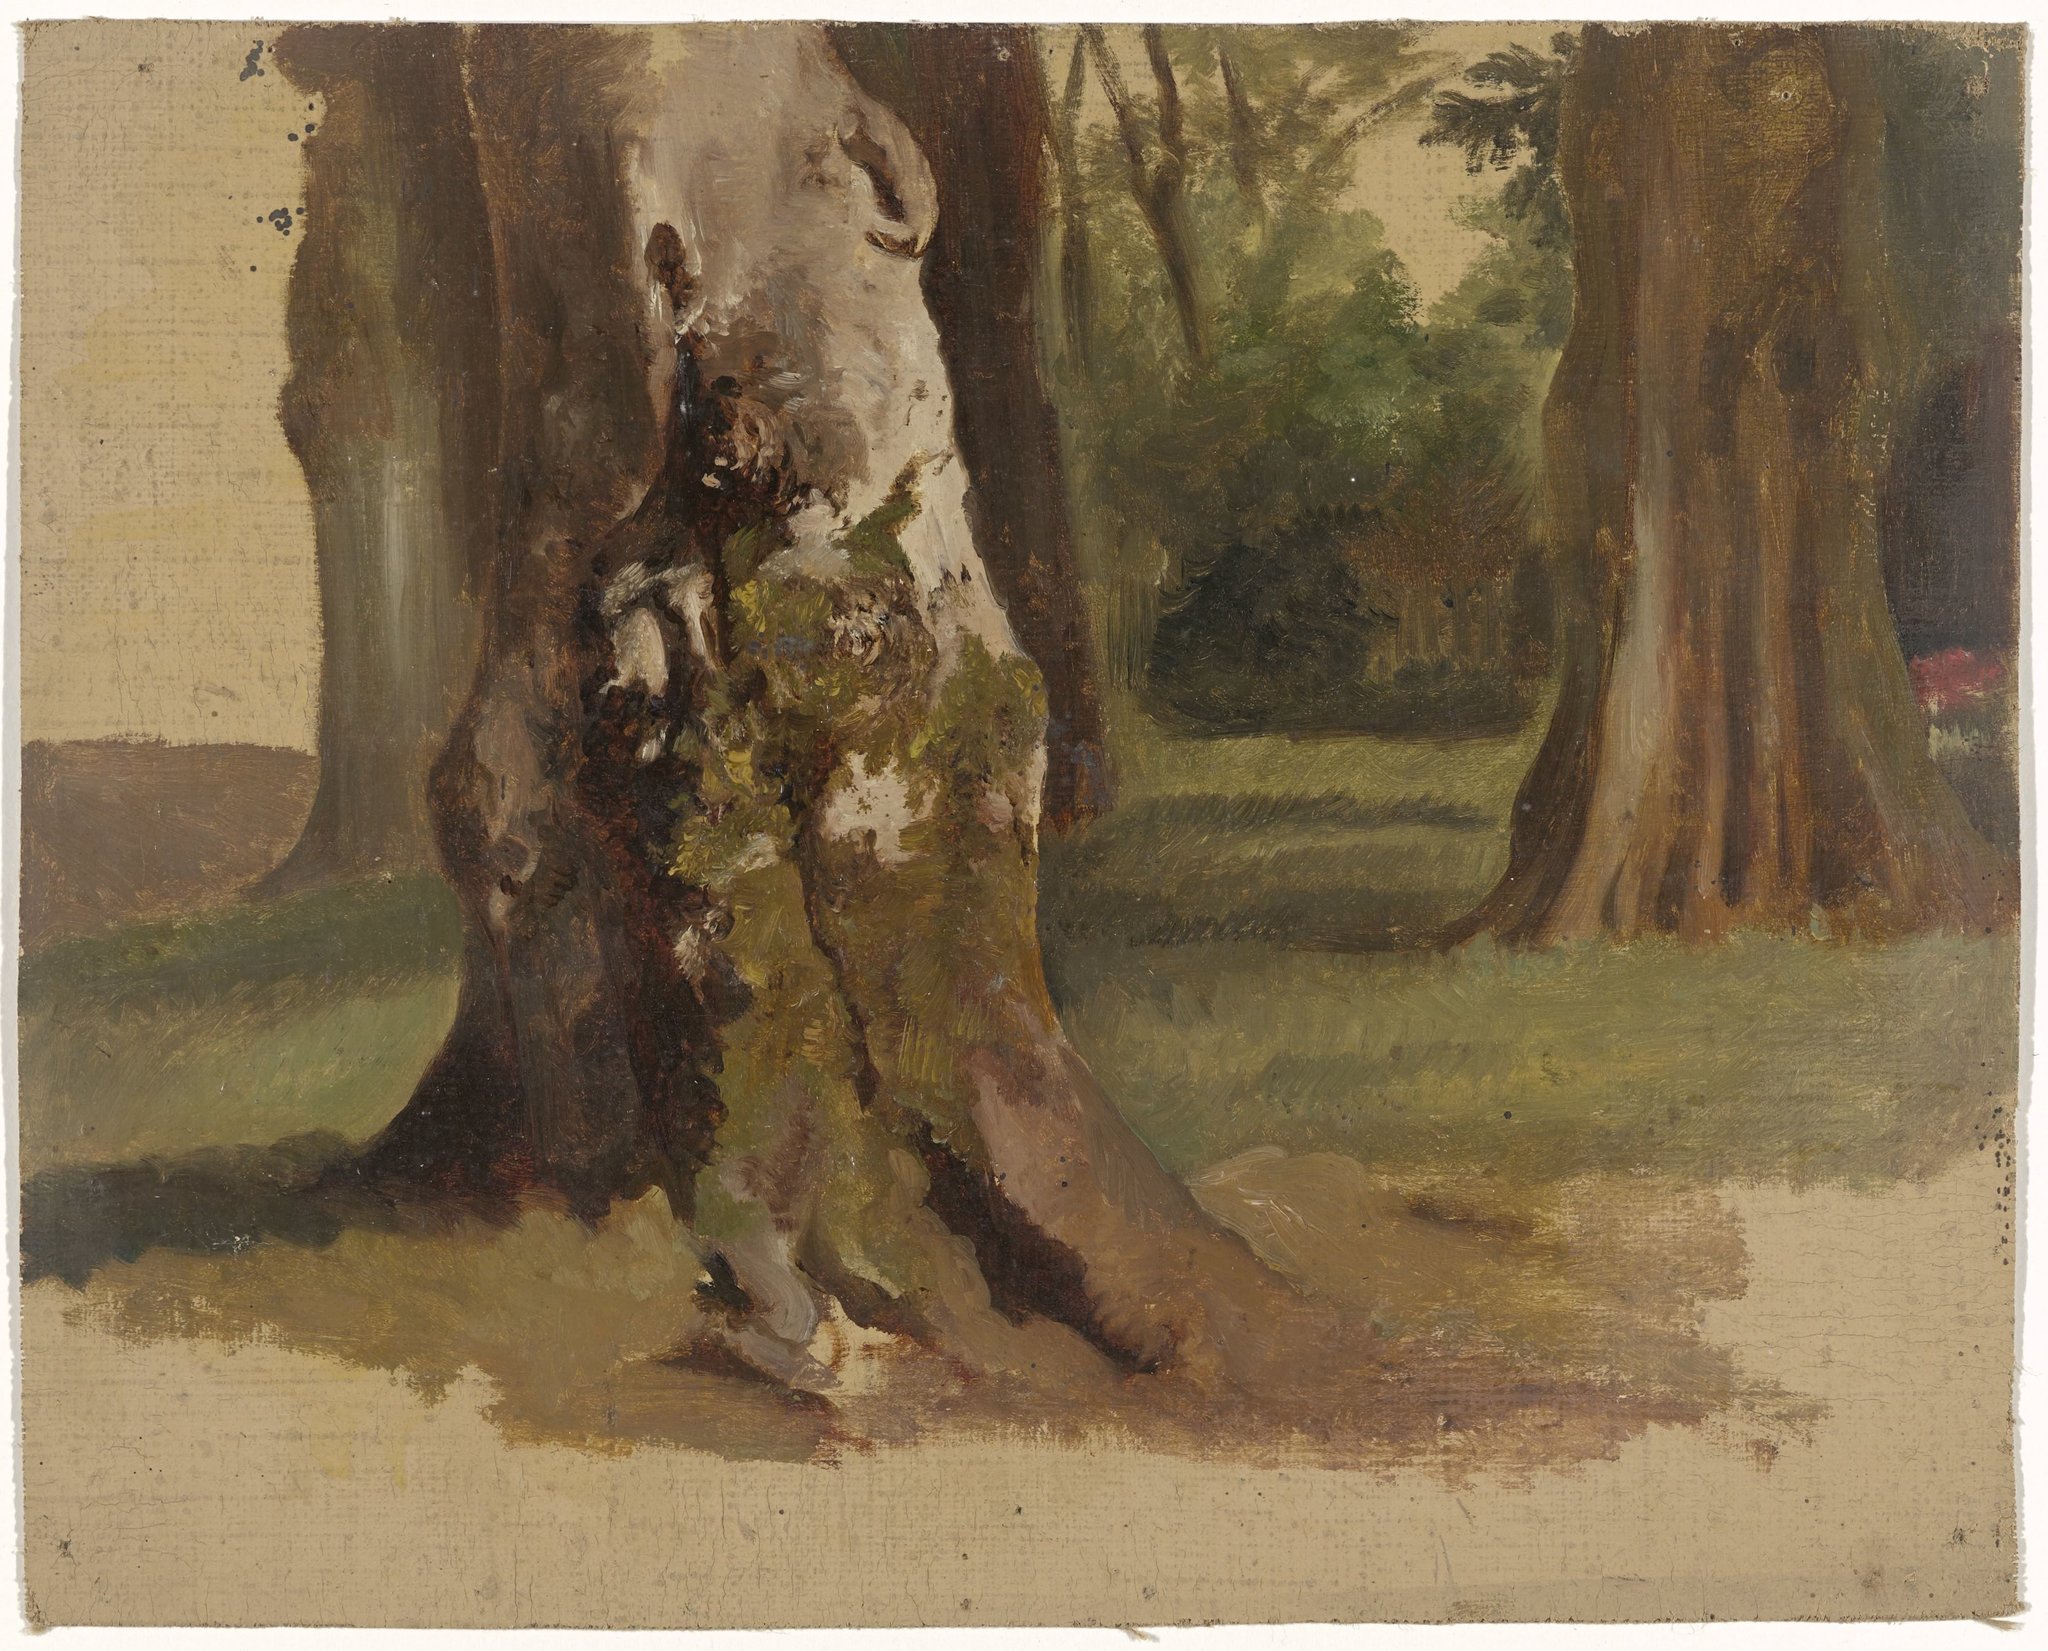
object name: oil sketch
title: Boomstammen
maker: guillaume anne van der brugghen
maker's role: draughtsman, print maker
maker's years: 1812-1891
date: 1821-1891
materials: linen, oil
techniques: brush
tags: trees